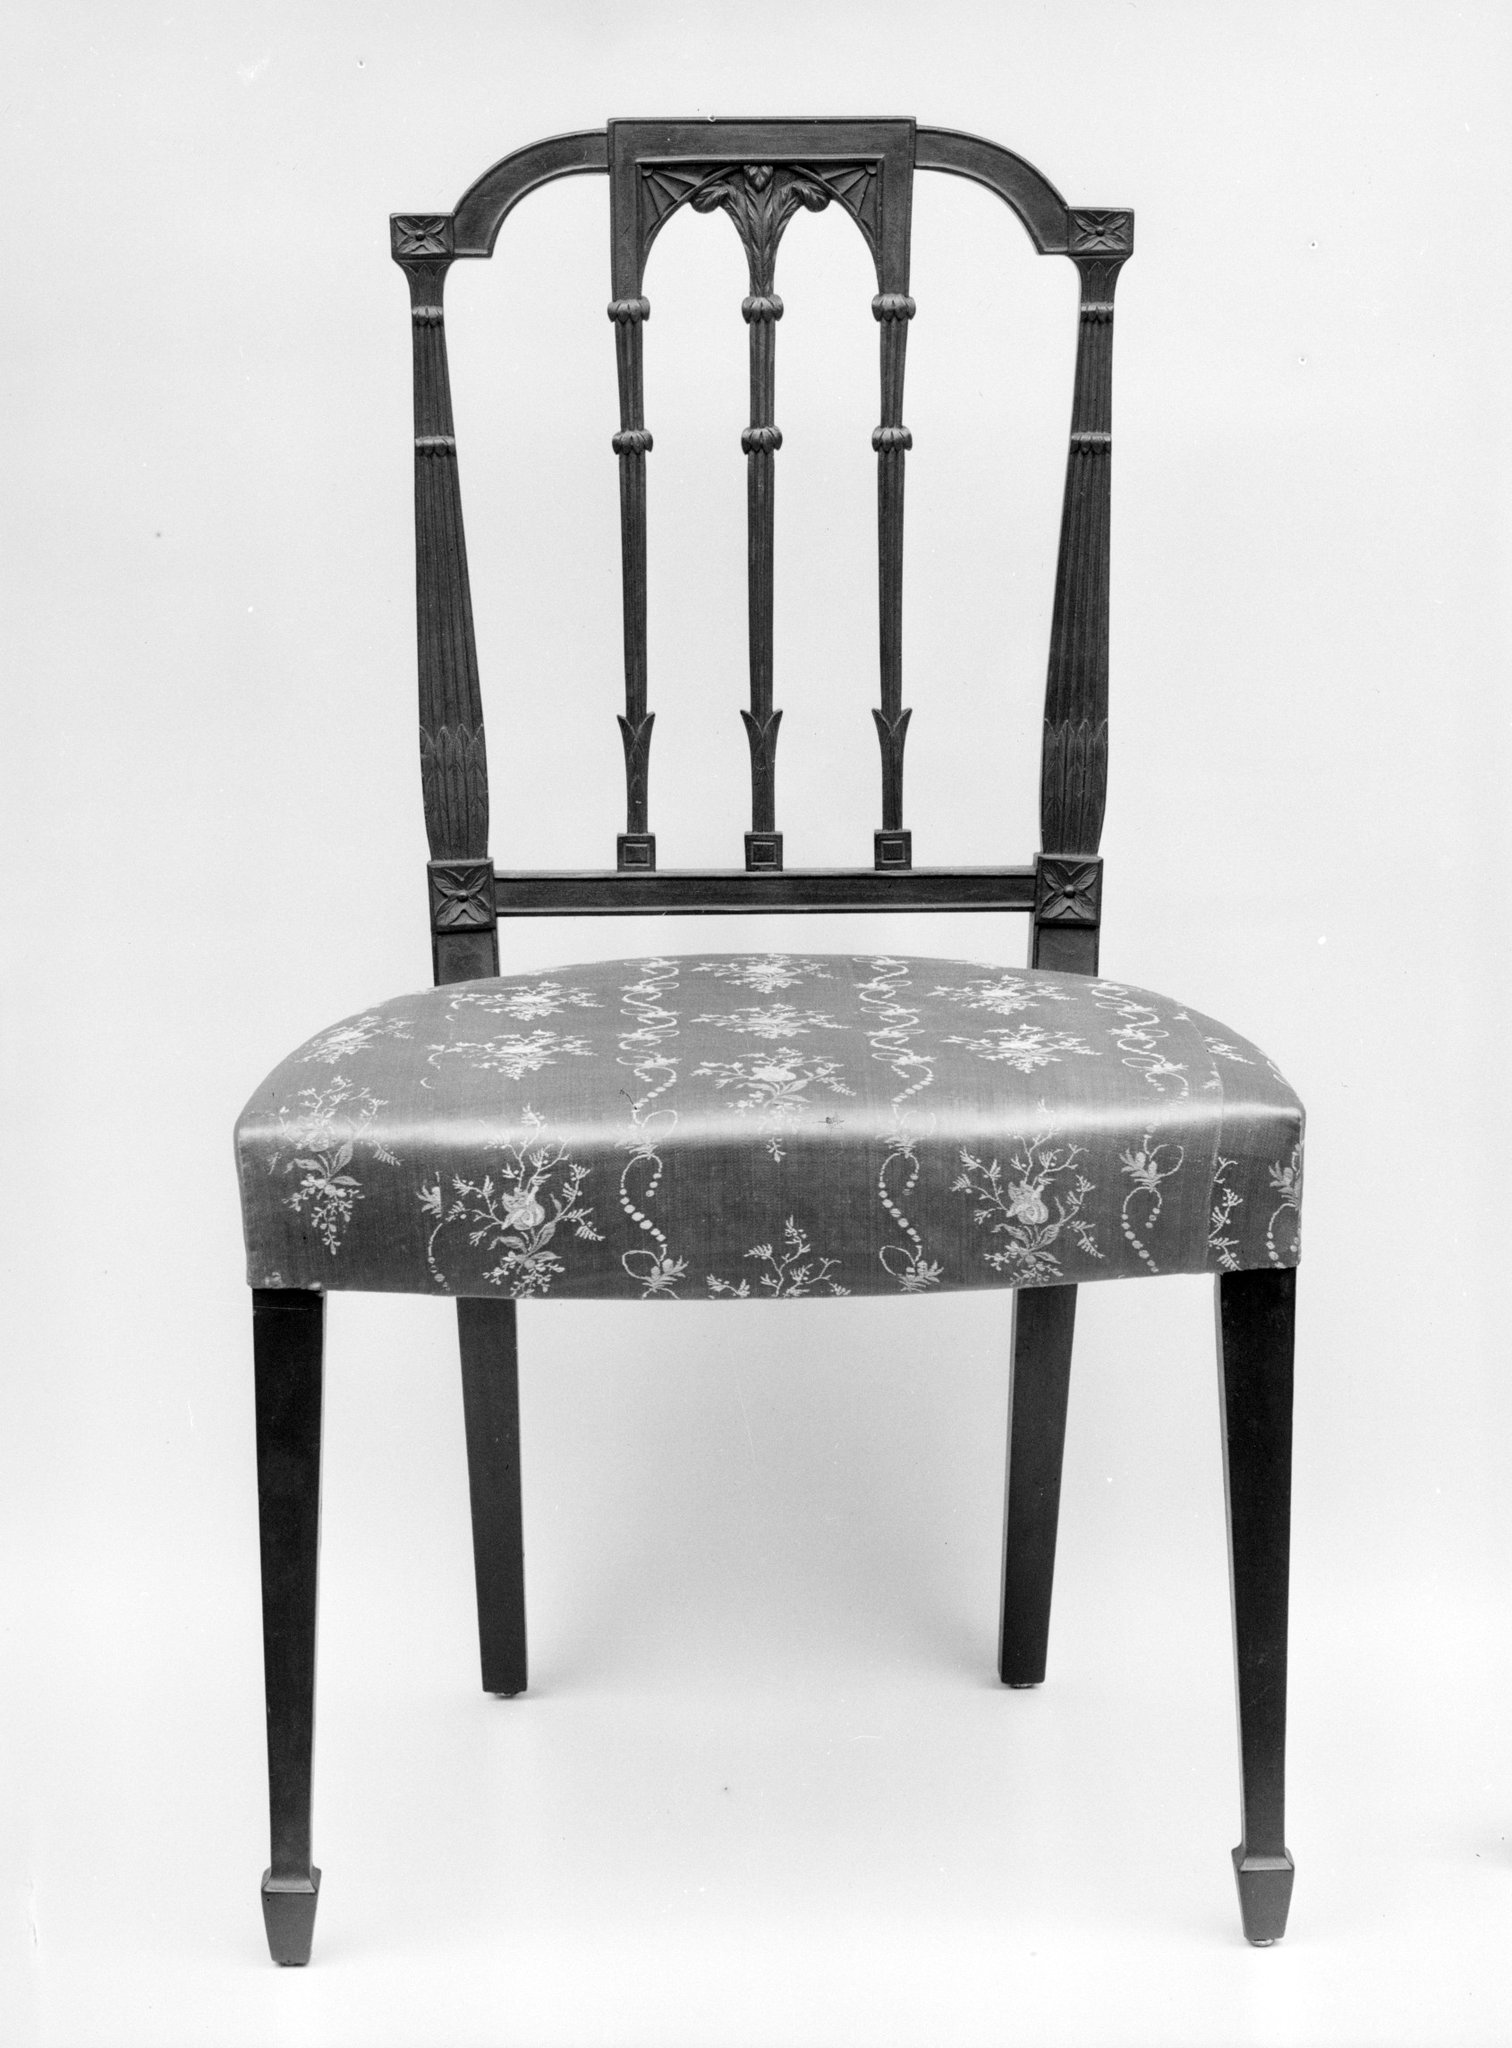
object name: side chair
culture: american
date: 1795-1810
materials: wood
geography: united states